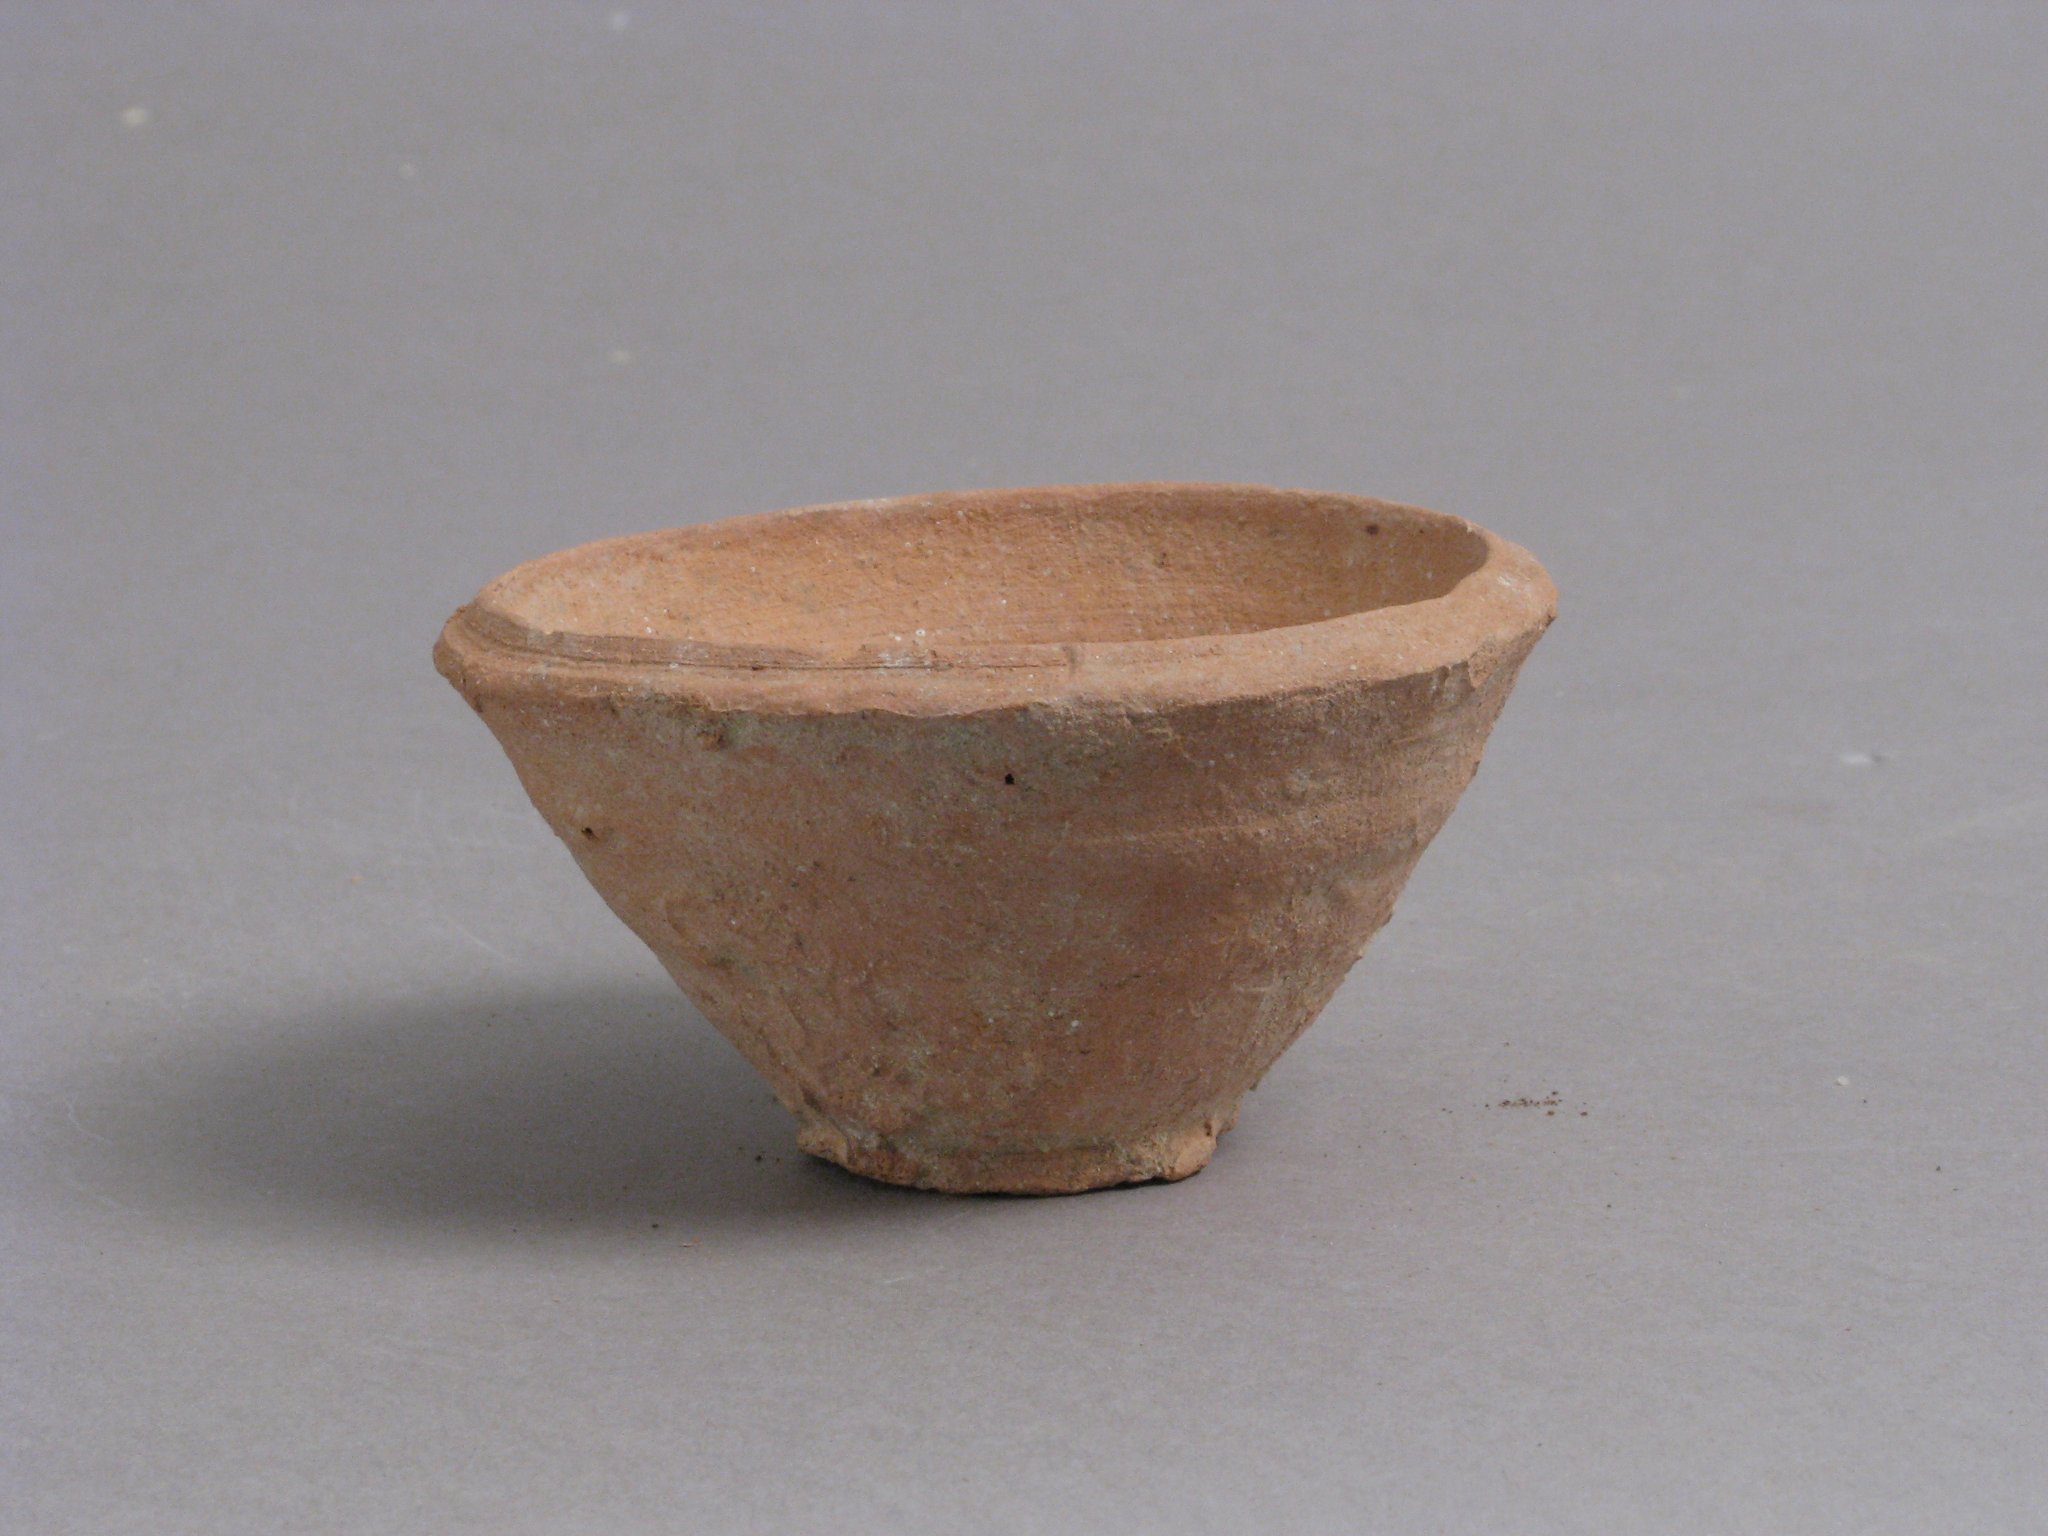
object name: bowl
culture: coptic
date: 301-700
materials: earthenware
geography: egypt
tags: bowls